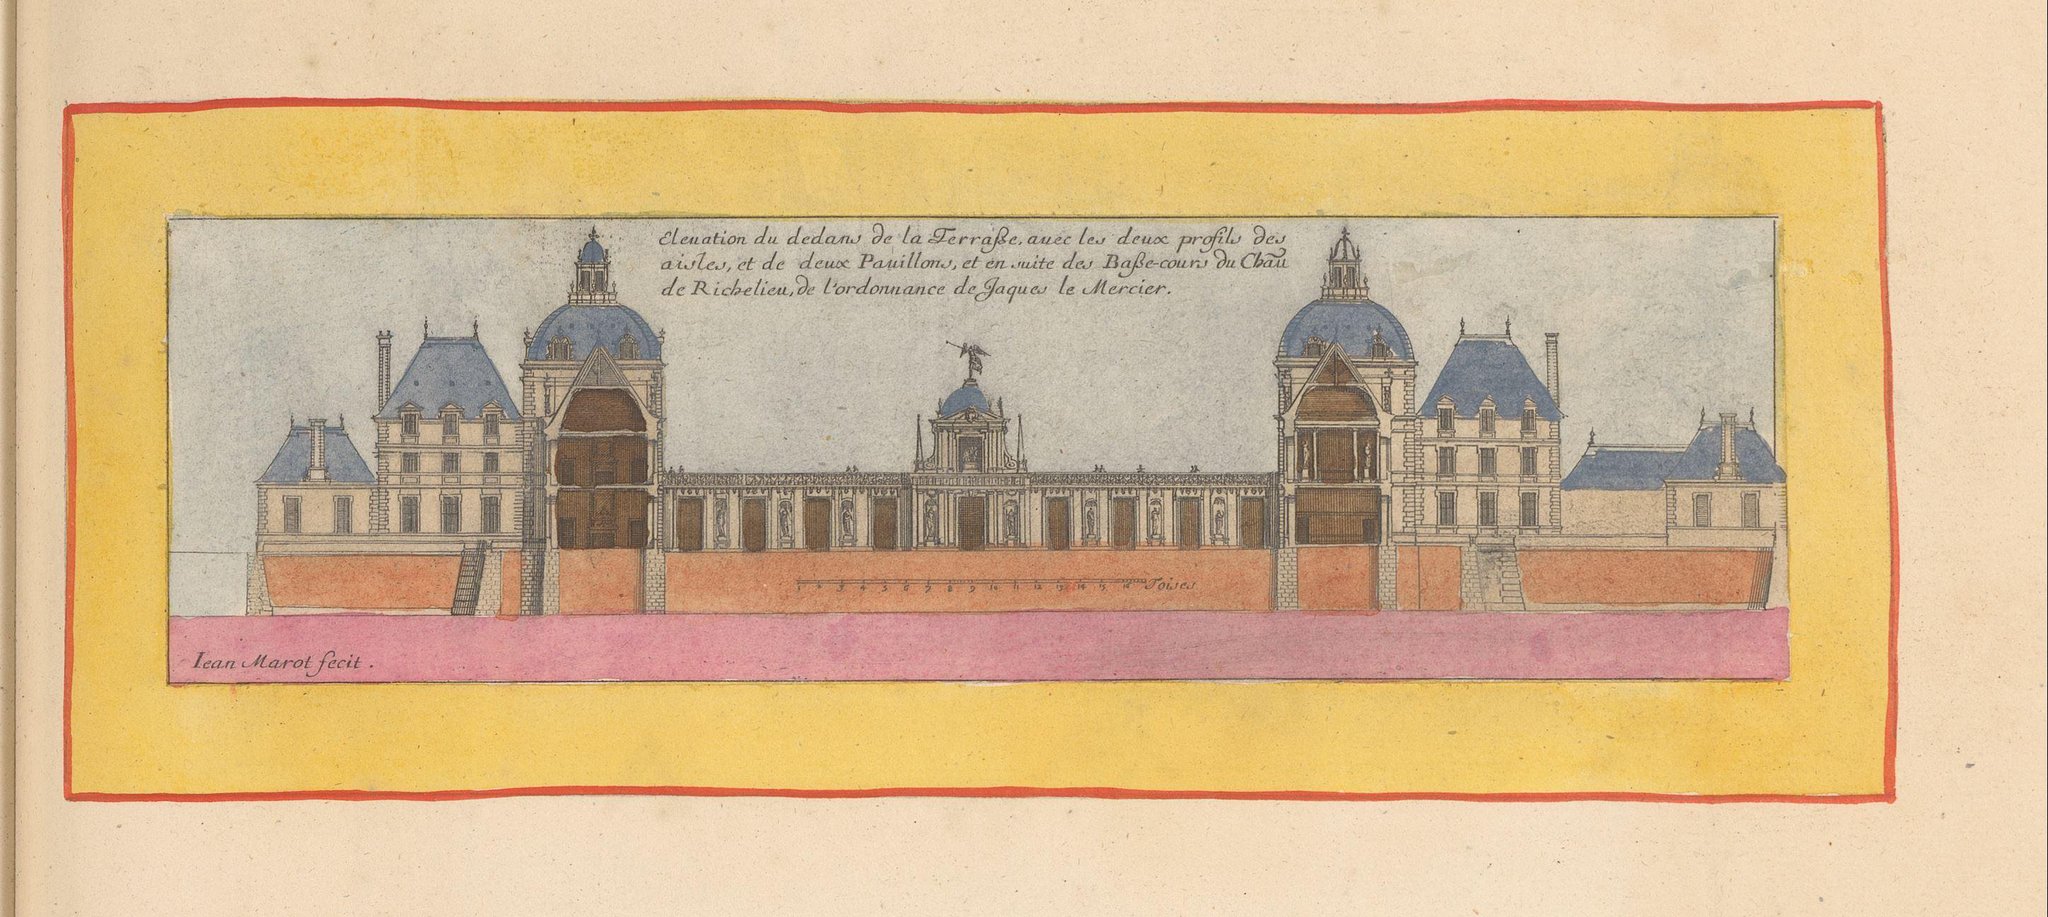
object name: album leaf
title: Le magnifique chasteau de Richelieu, ou les plans, les fassades, les elevations et profils du dit chasteau (...)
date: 1629-1679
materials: paper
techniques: etching, hand coloring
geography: the hague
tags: castle, series of designs, models, etc. of one architectural project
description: Deze prent maakt deel uit van een album.